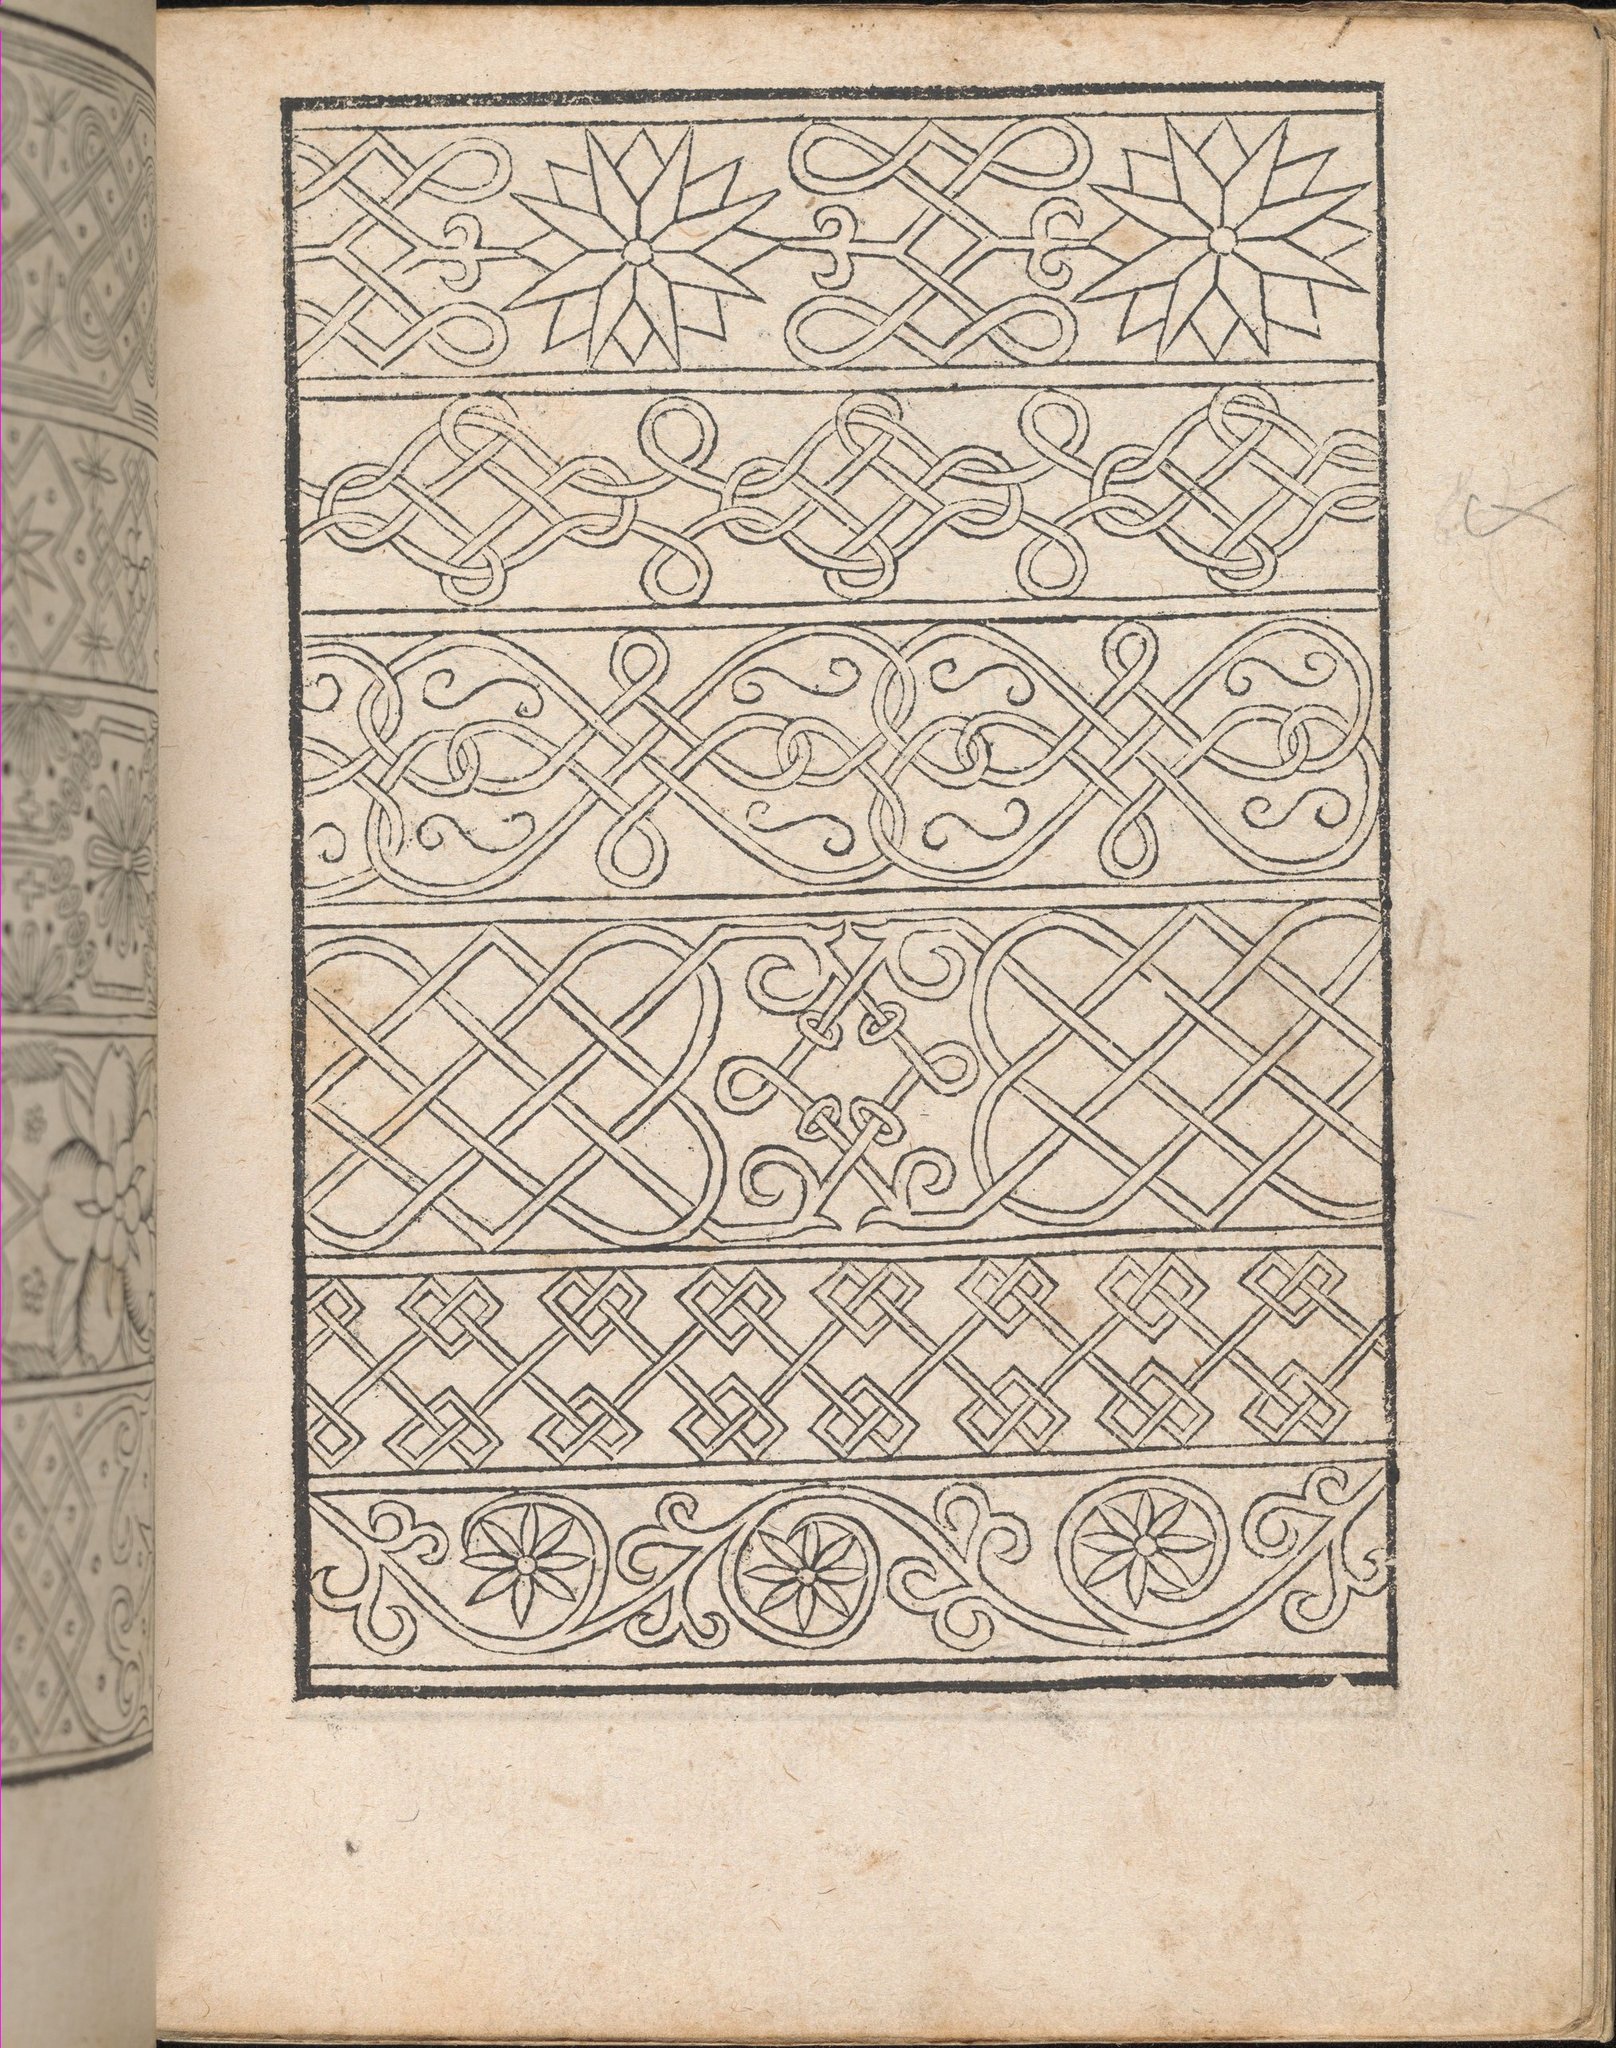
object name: book print ornament architecture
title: New Modelbüch allen Nägerin u. Sydenstickern (Page 8r)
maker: hans hoffman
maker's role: designer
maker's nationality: german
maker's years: 1556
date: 1556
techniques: woodcut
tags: ornament